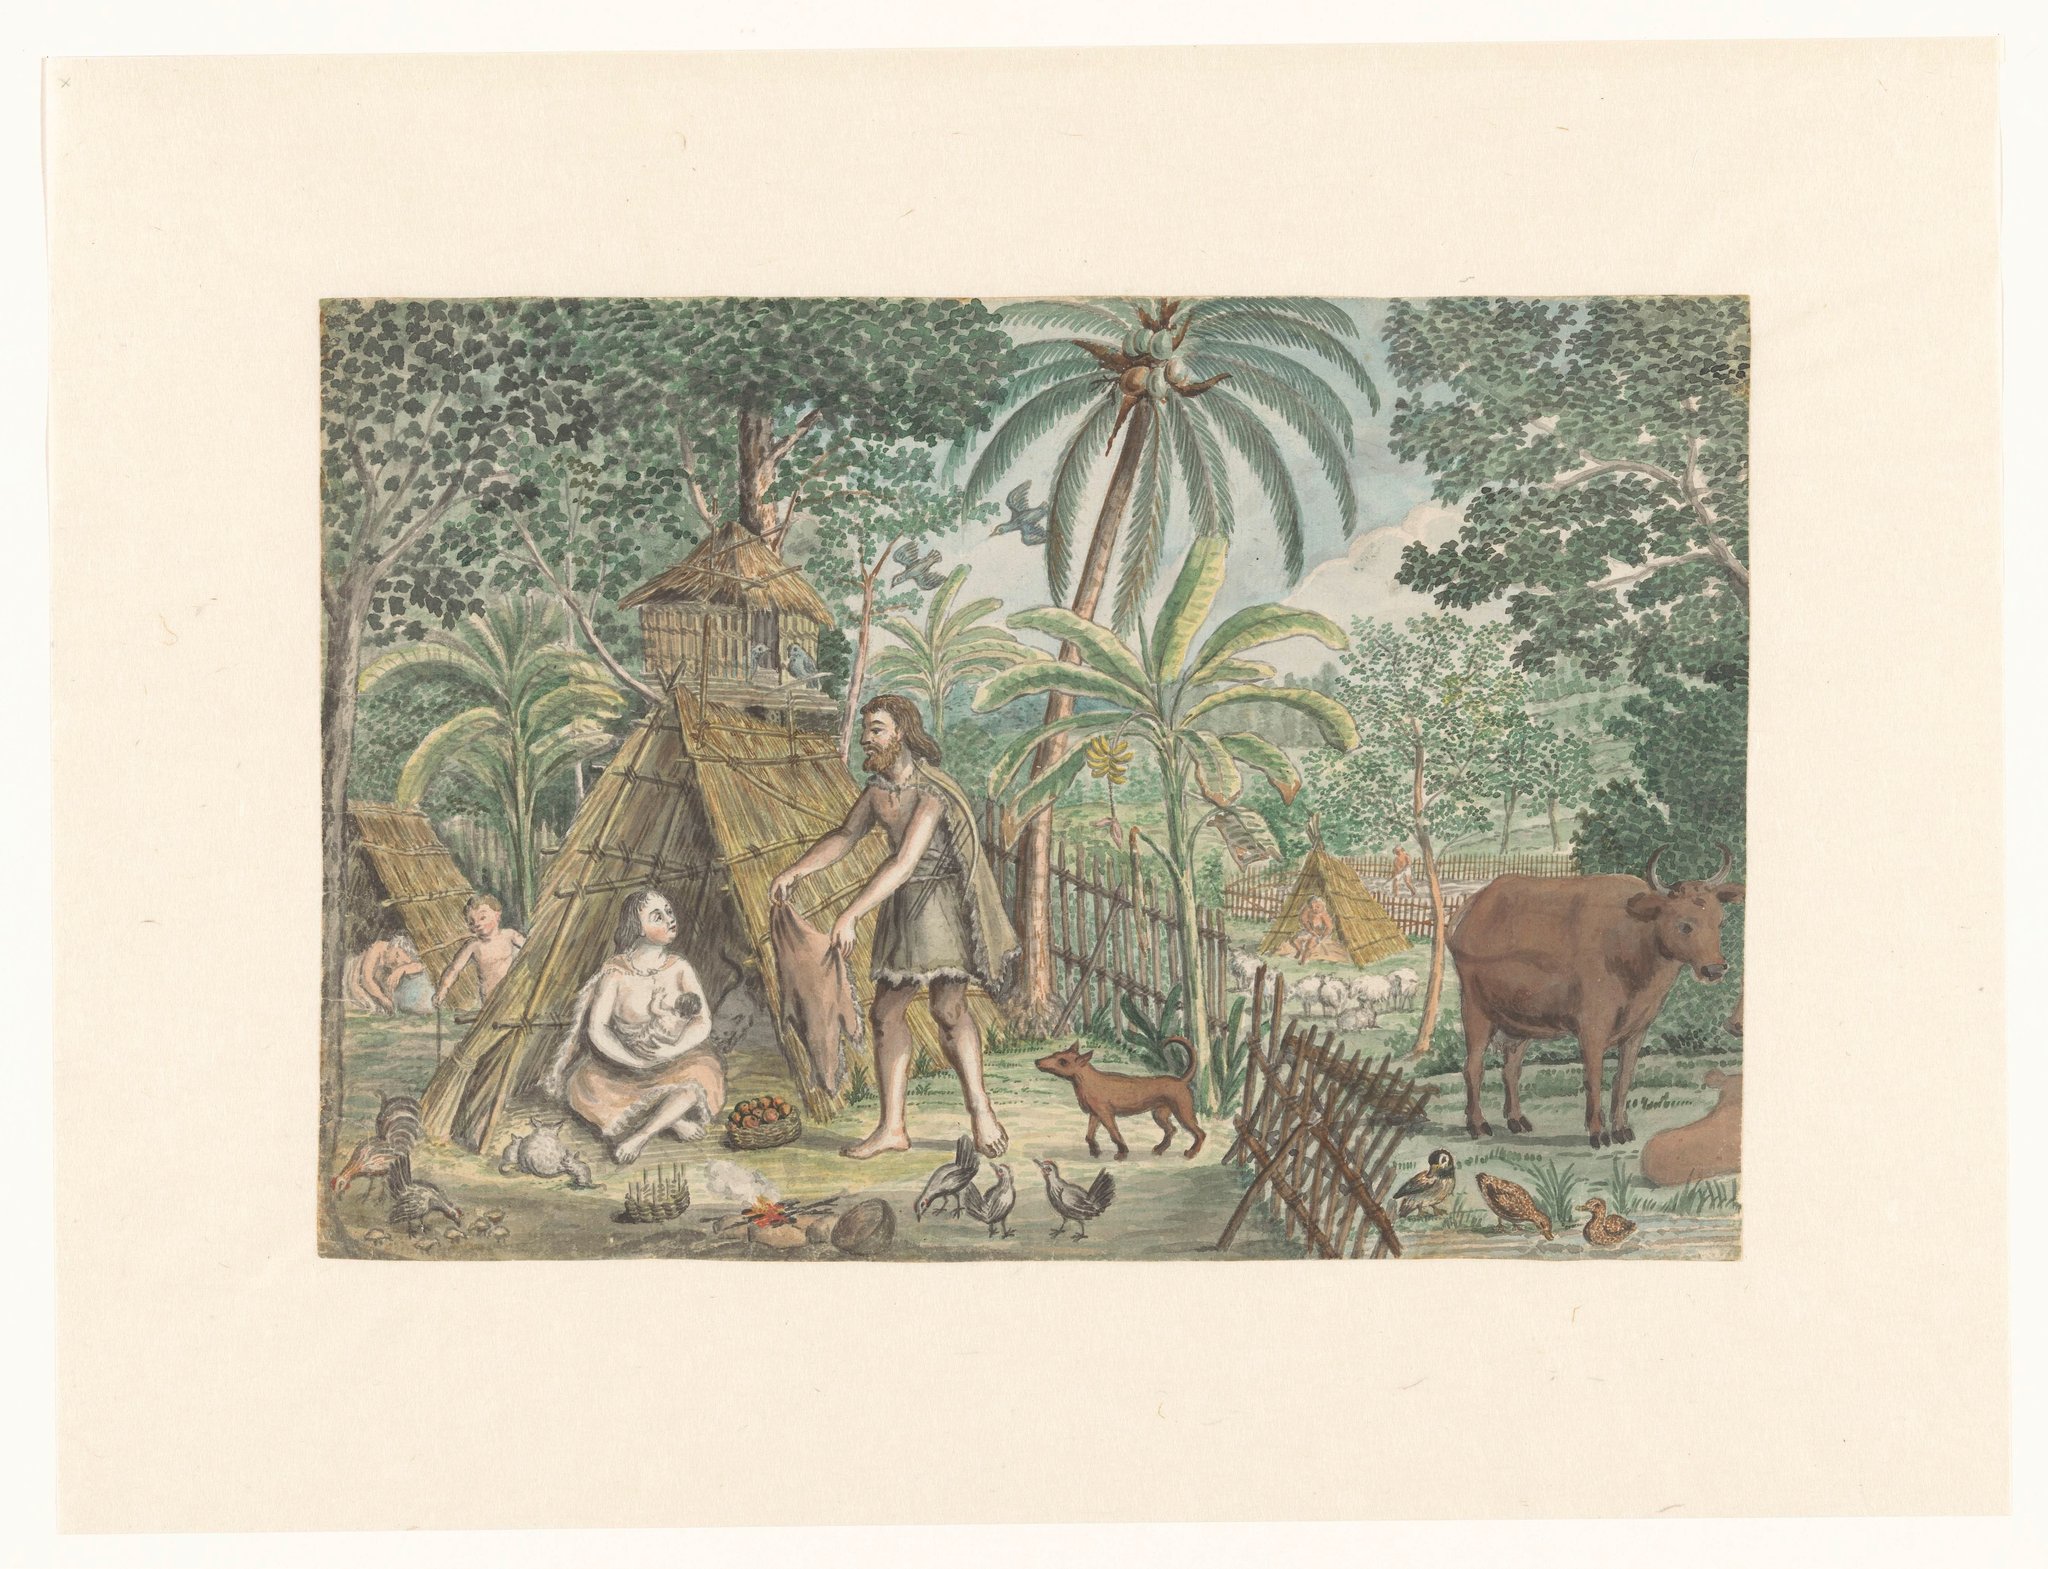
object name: drawing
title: Adam en Eva in een utopisch dorpstafereel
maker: jan brandes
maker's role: draughtsman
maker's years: 1743-1808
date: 1779-1785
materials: paper, pencil, watercolor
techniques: brush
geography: taiwan strait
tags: landscapes in the non-temperate zone, exotic landscapes - kk - ideal landscapes, jungle - kk - ideal landscapes, adam and eve (not in biblical context), pastorals, arcadian scenes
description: Fantasievoorstelling van een idyllische, primitieve nederzetting met meerdere families van blanke mensen in beestenvellen in tropisch landschap. Mogelijk een verbeelding van het verhaal van Adam en Eva.